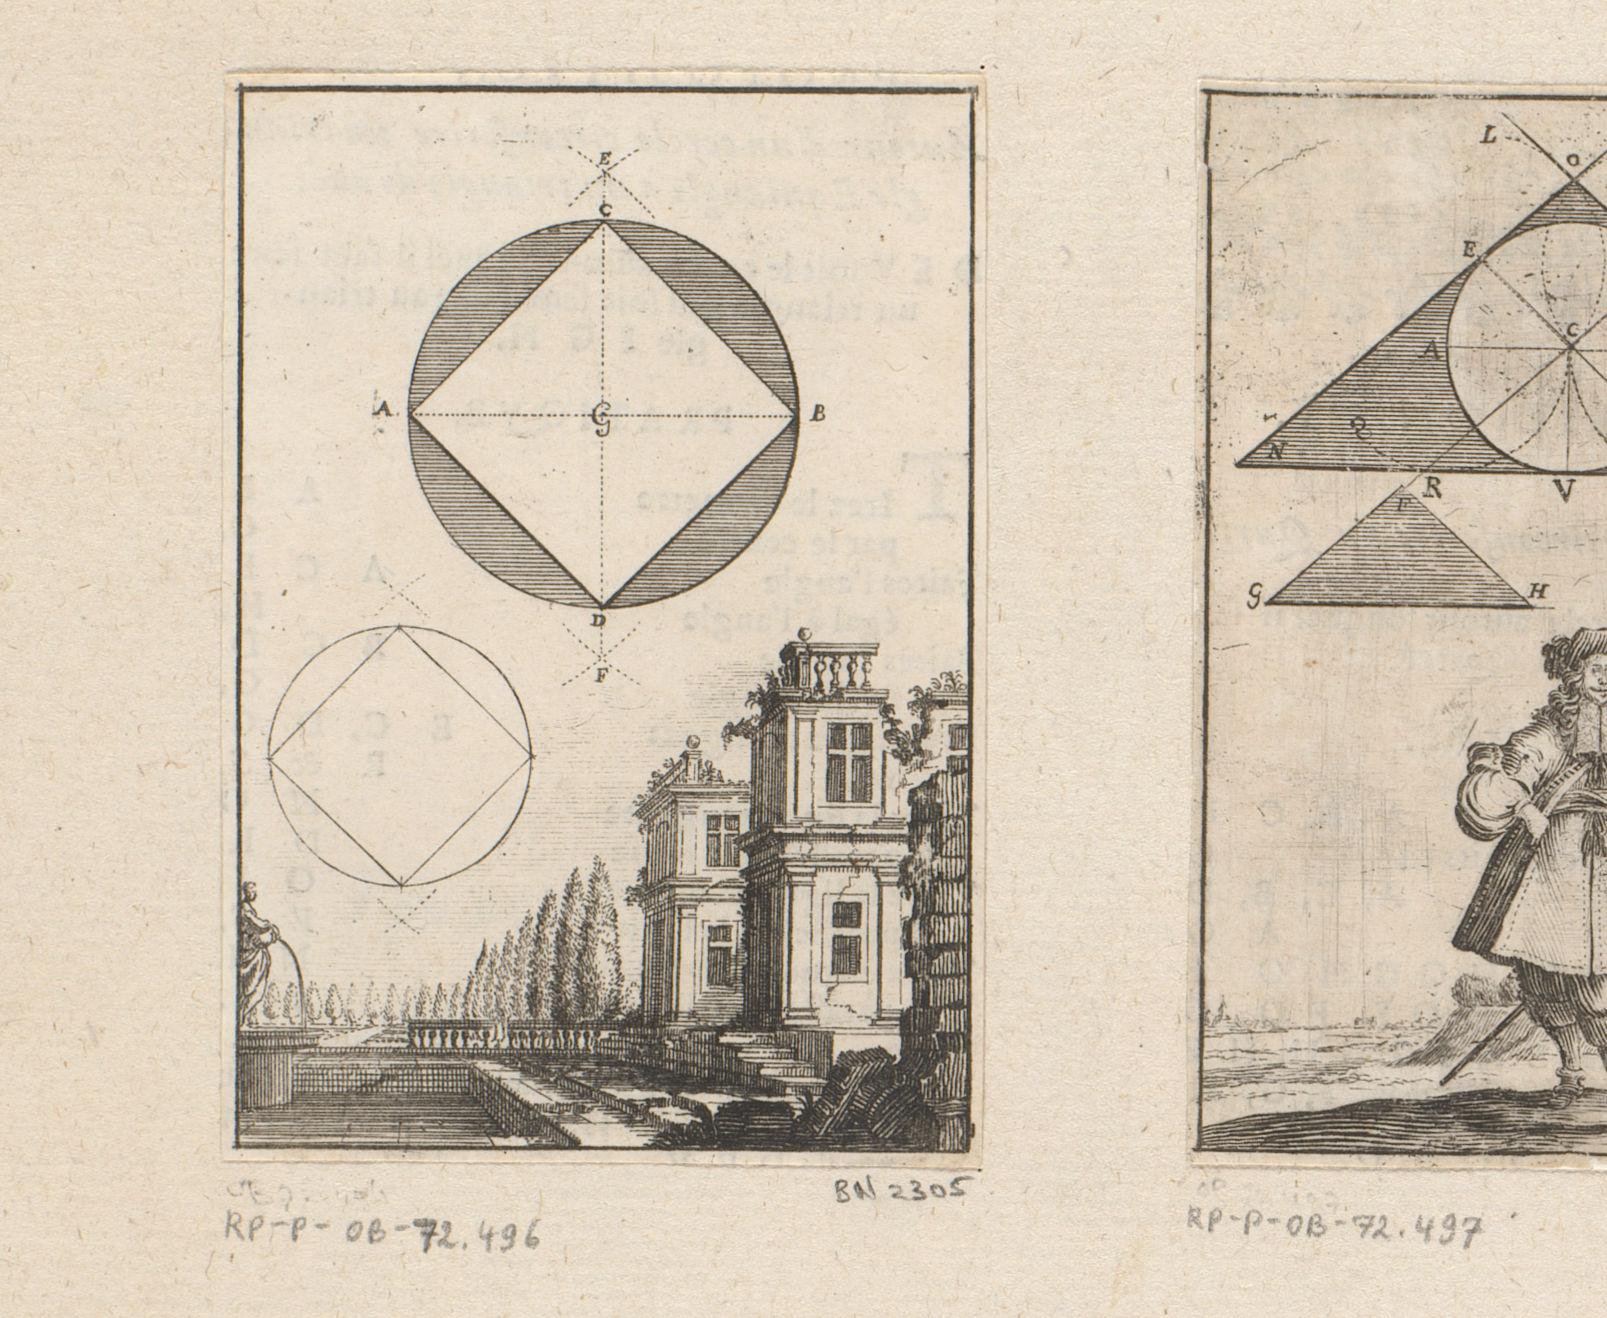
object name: book illustration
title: Vierkant rond een cirkel met onderaan ruïne van een paleis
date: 1669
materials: paper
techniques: etching, letterpress printing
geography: paris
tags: palace, landscape with ruins, planimetry, geometry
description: Prent uit: Pratique de la géometrie, sur le papier et sur le terrain. Avec un nouvel ordre et une méthode particulière. Parijs: Thomas Jolly, 1669.